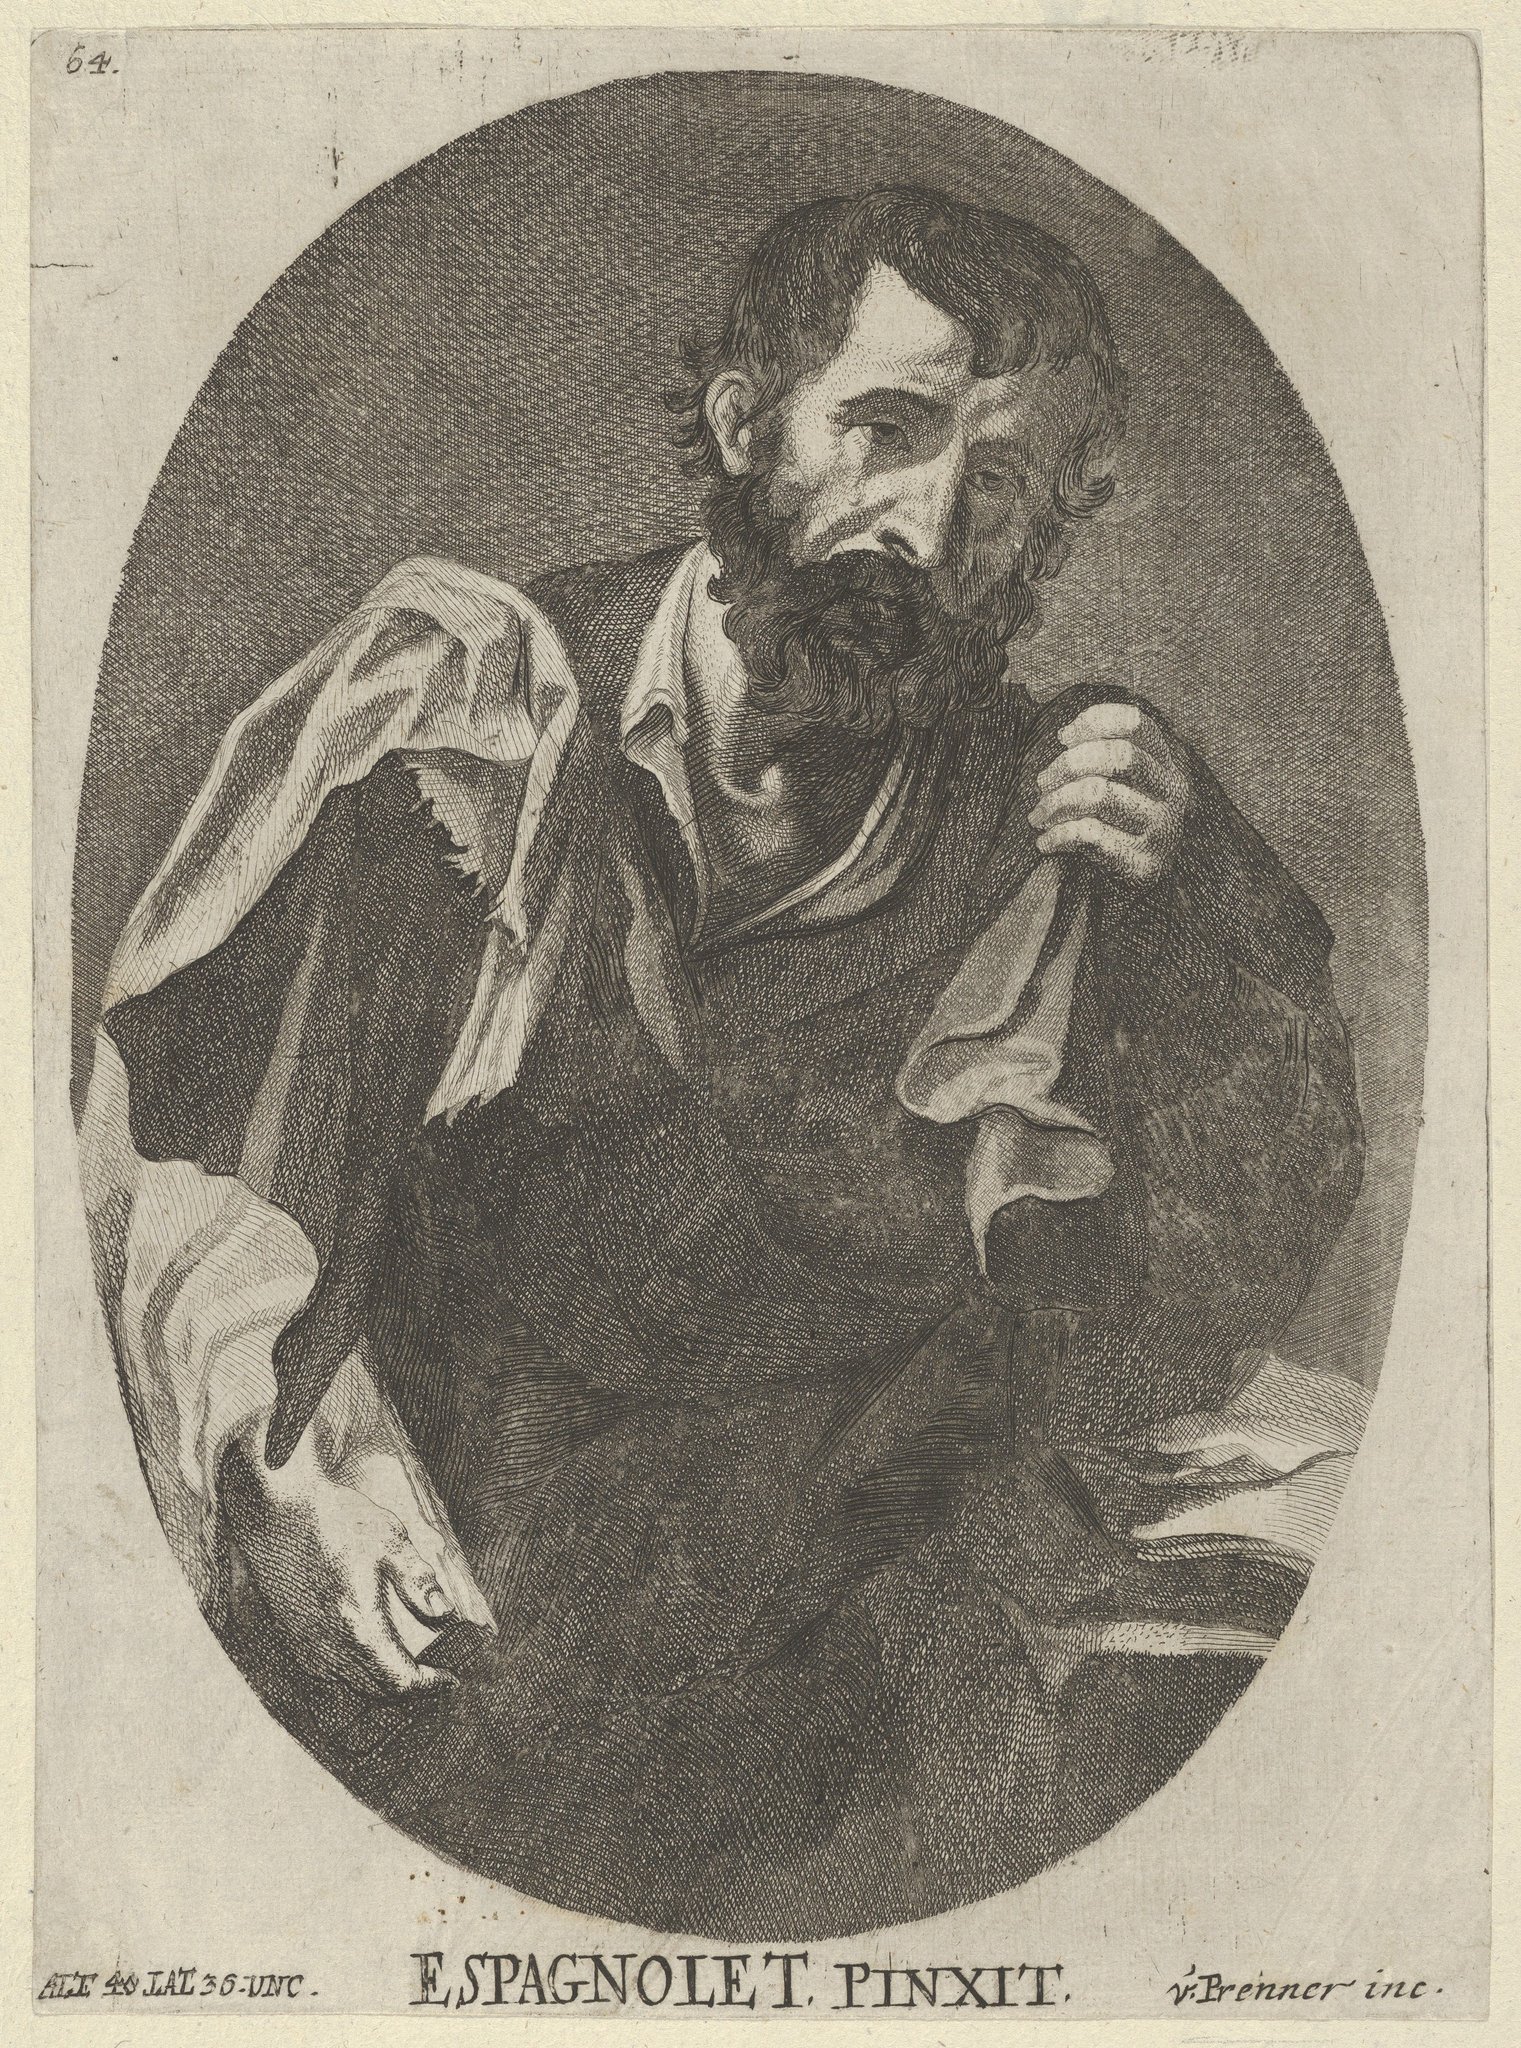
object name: print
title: A man, possibly a scholar or philosopher, from a portfolio of reproductions of the Imperial Gallery of Paintings in Vienna; plate 64 of the series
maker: anton joseph von prenner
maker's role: artist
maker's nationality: austrian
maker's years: 1683-1761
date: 1728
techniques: etching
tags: men,philosophers